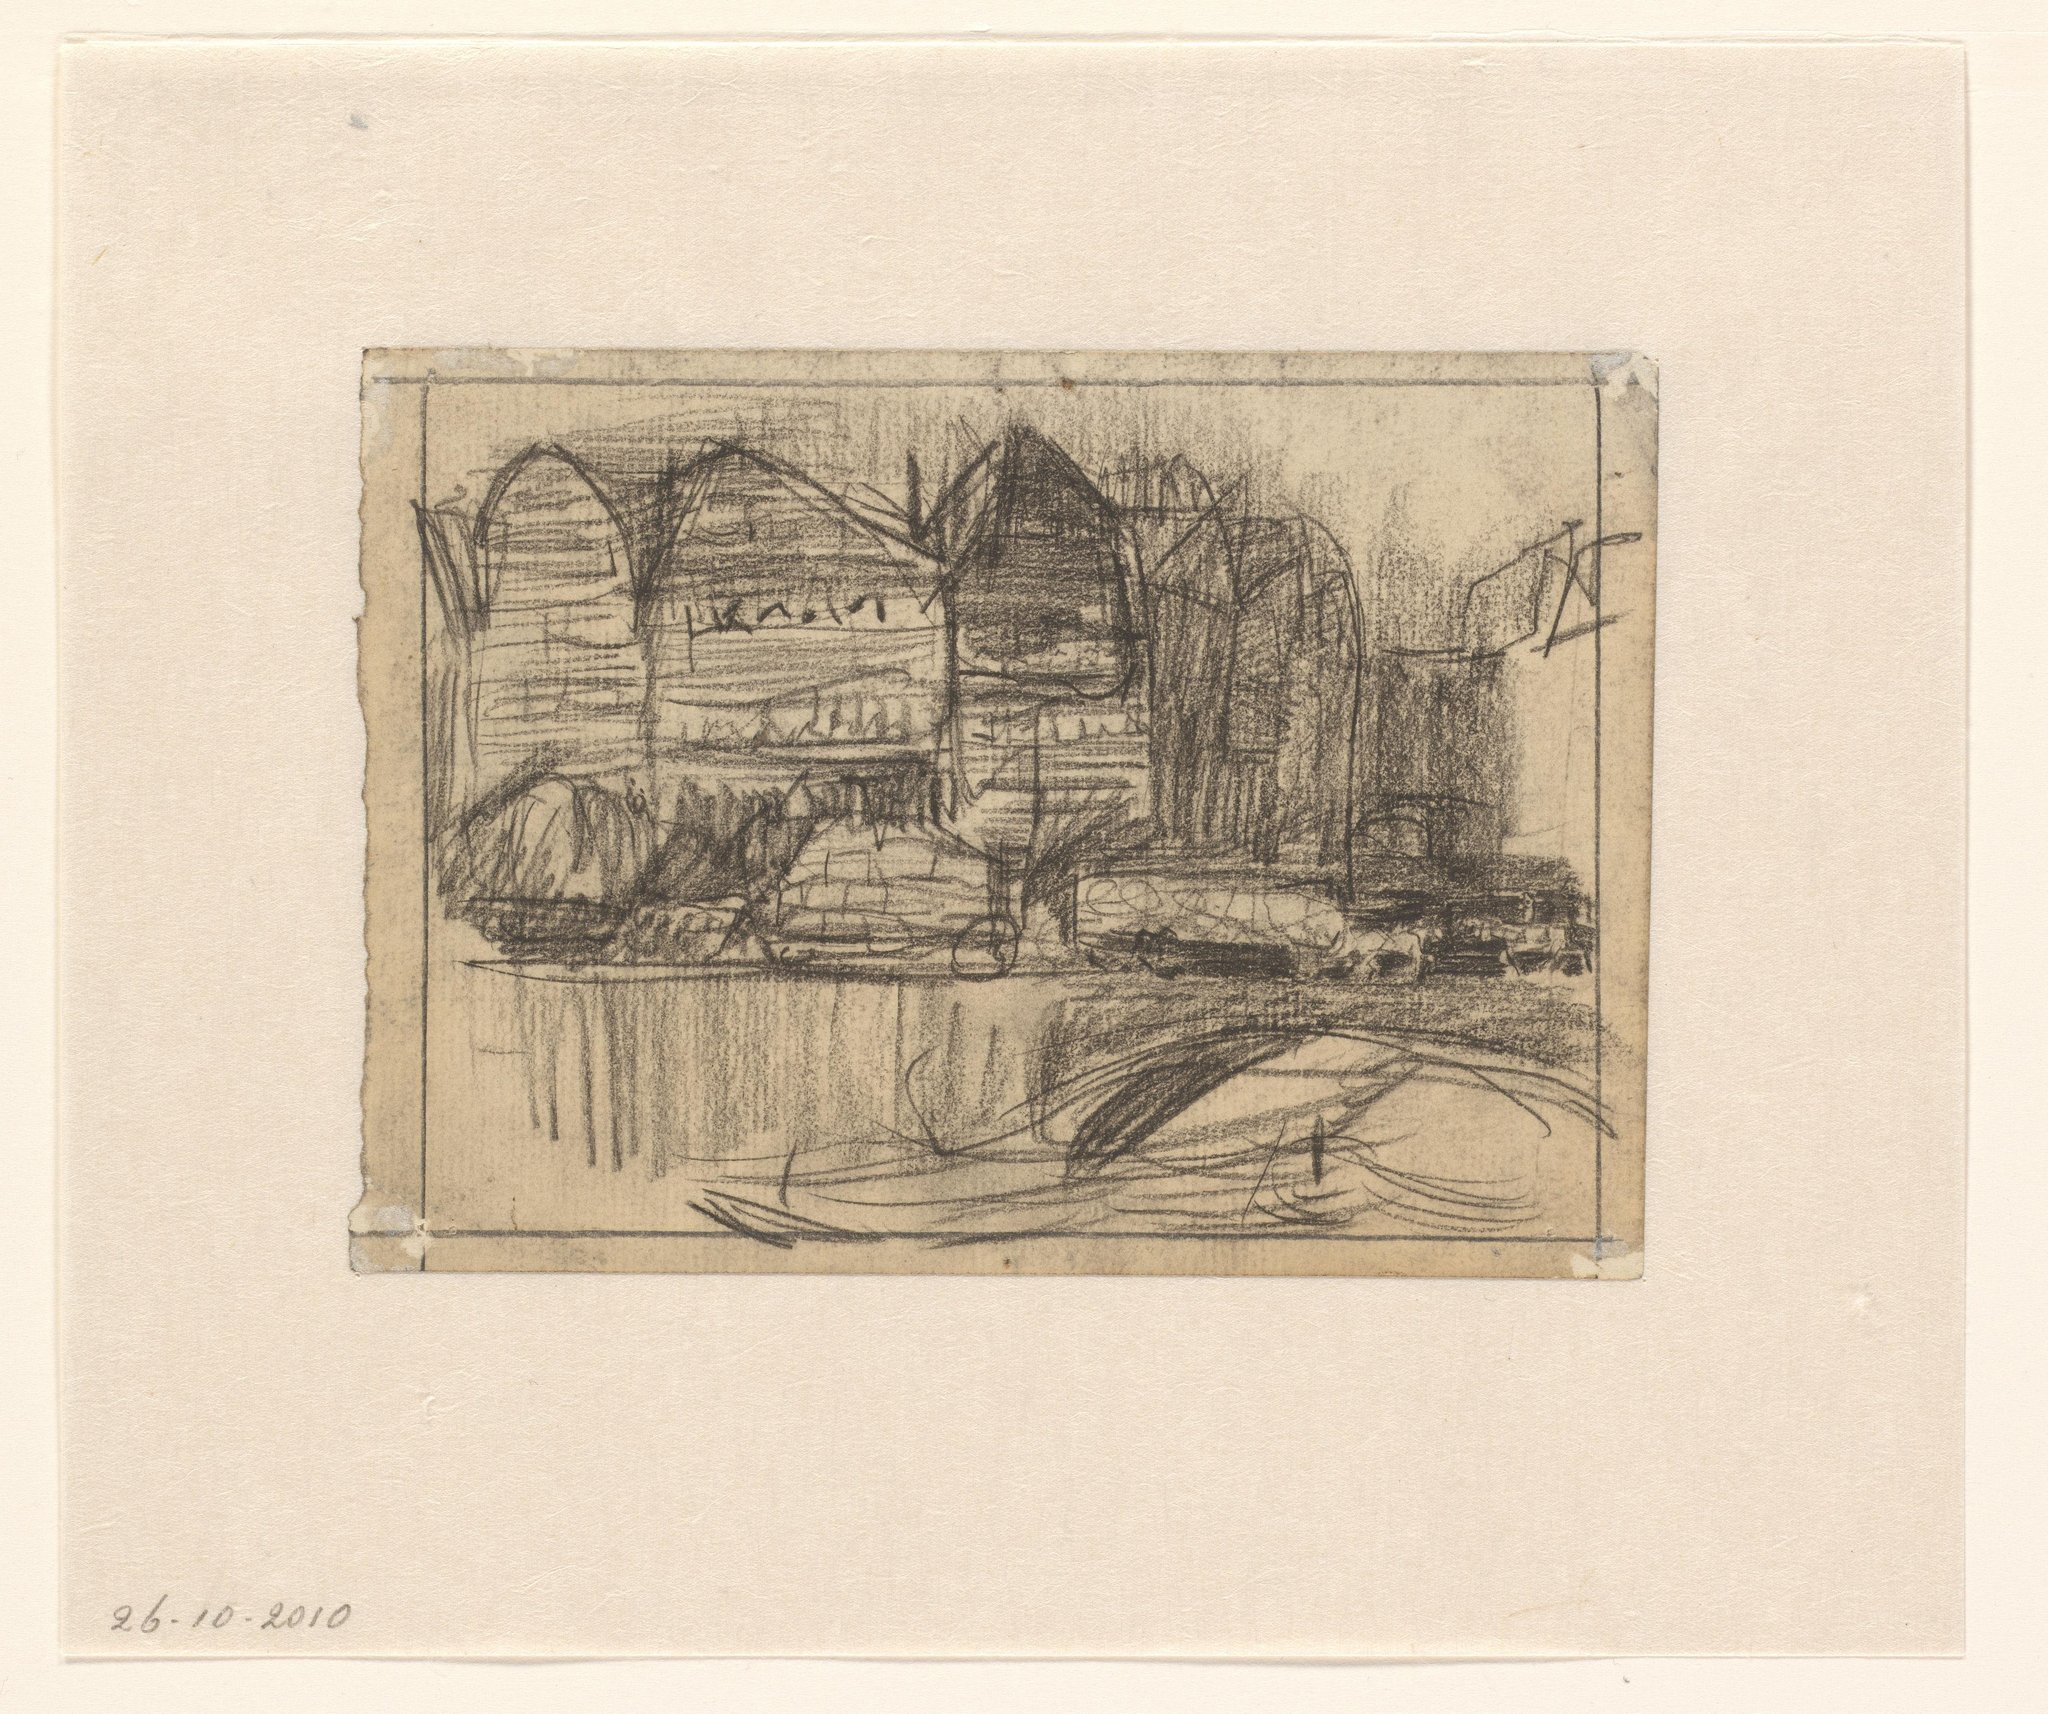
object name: drawing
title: Rijtje huizen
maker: jan veth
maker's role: designer, draughtsman, painter, print maker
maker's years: 1864-1925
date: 1874-1925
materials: chalk, paper